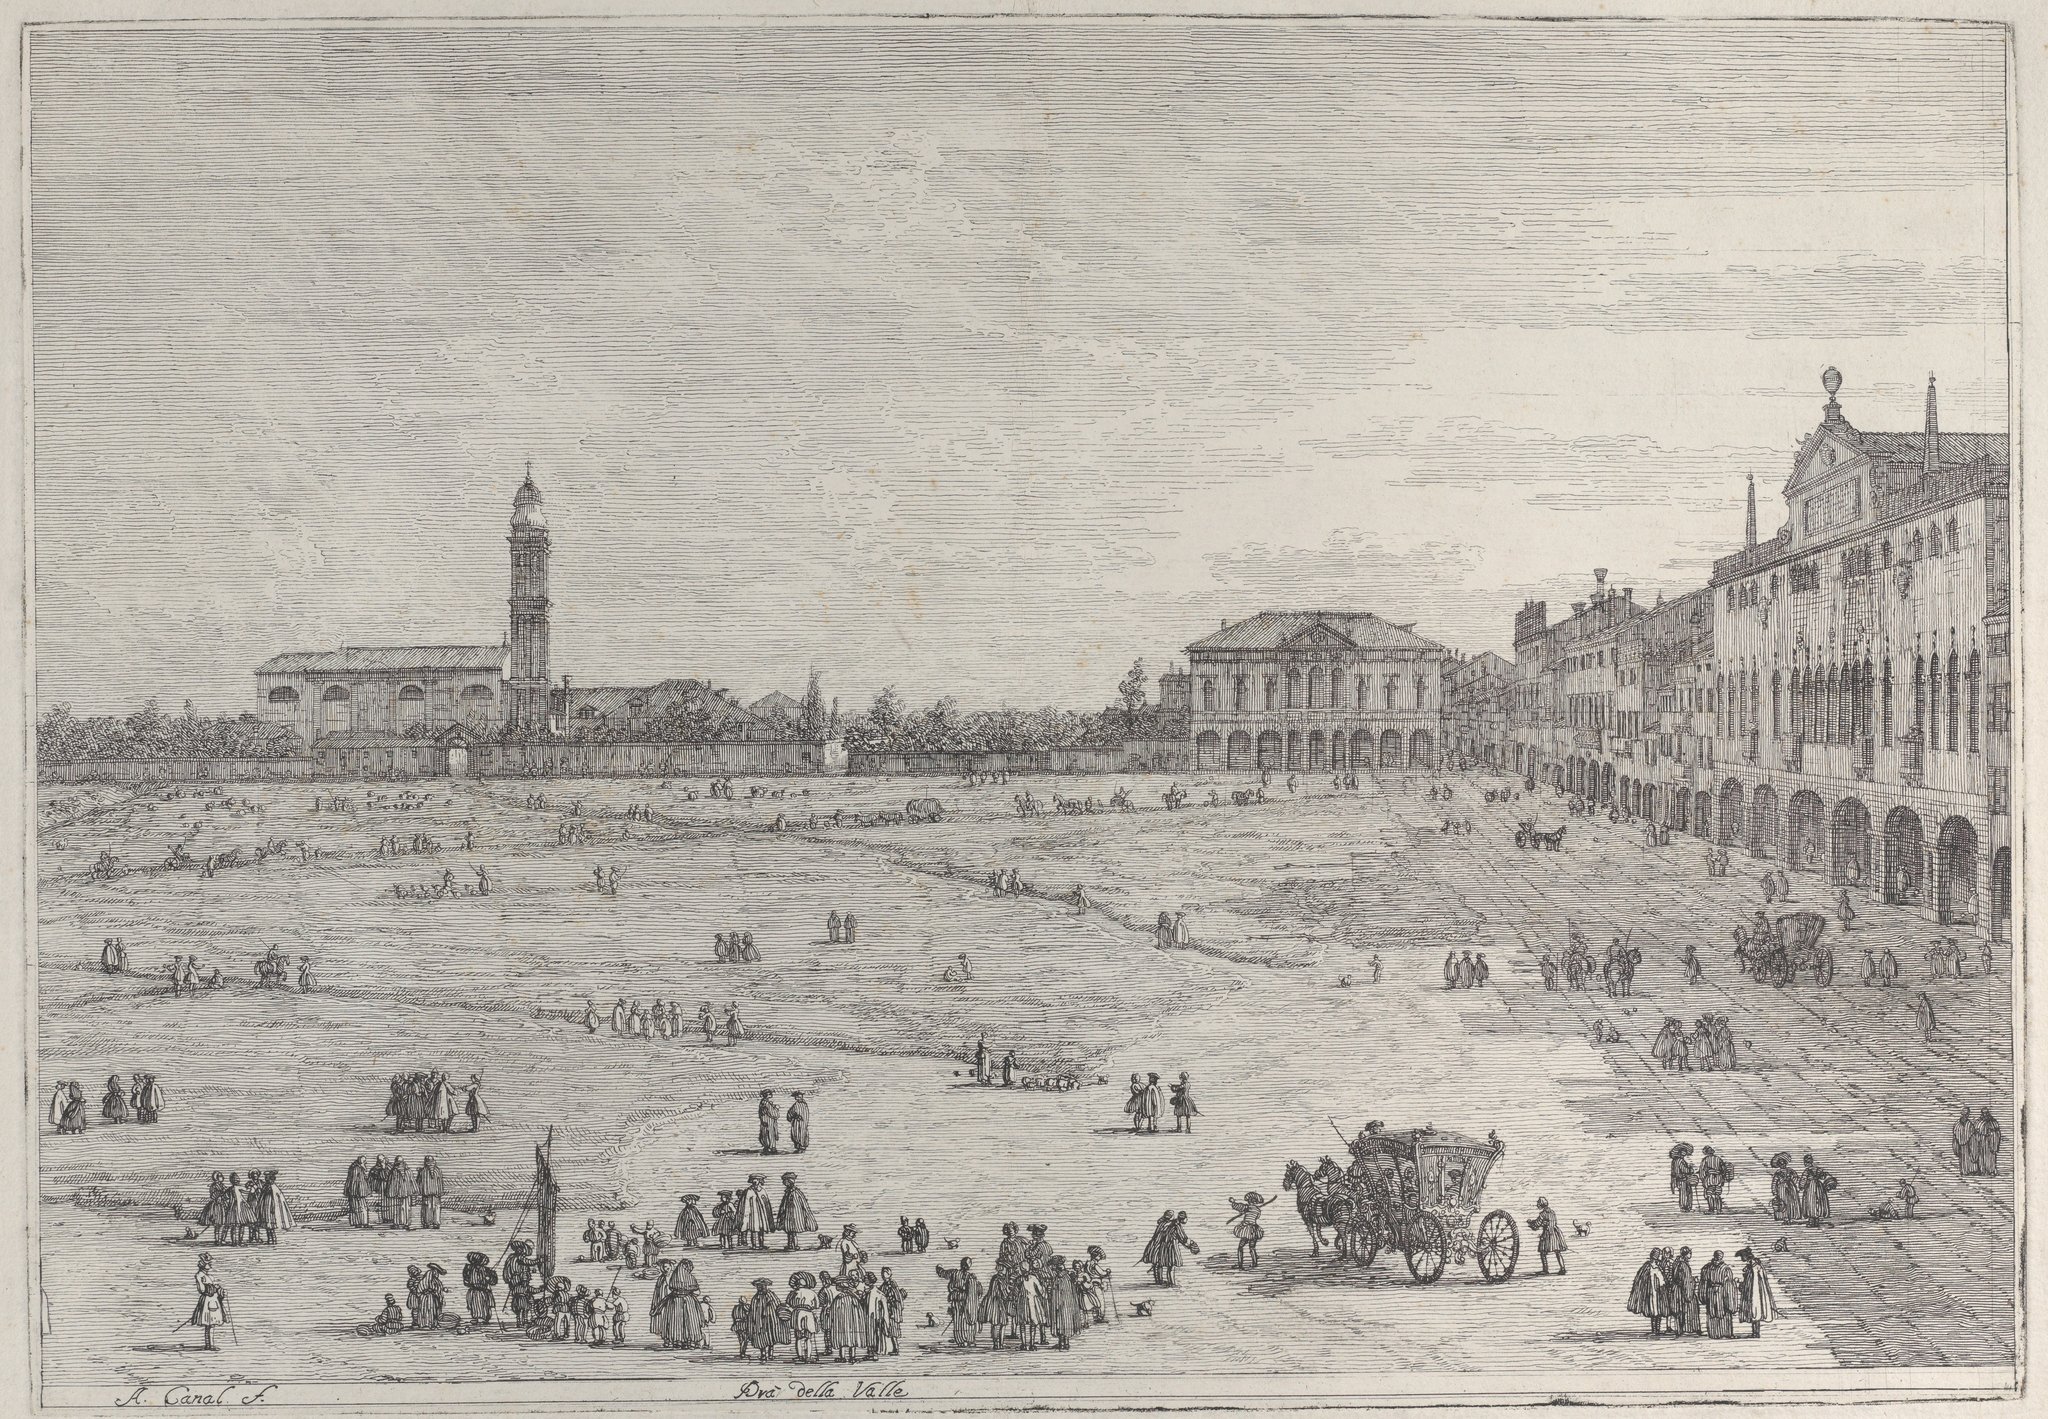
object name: print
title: Prà della Valle: the right half of the square of Prà della Valle in Padua, with the Colleggio Universitario at right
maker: canaletto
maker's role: artist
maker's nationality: italian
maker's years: 1697-1768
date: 1735-1746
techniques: etching